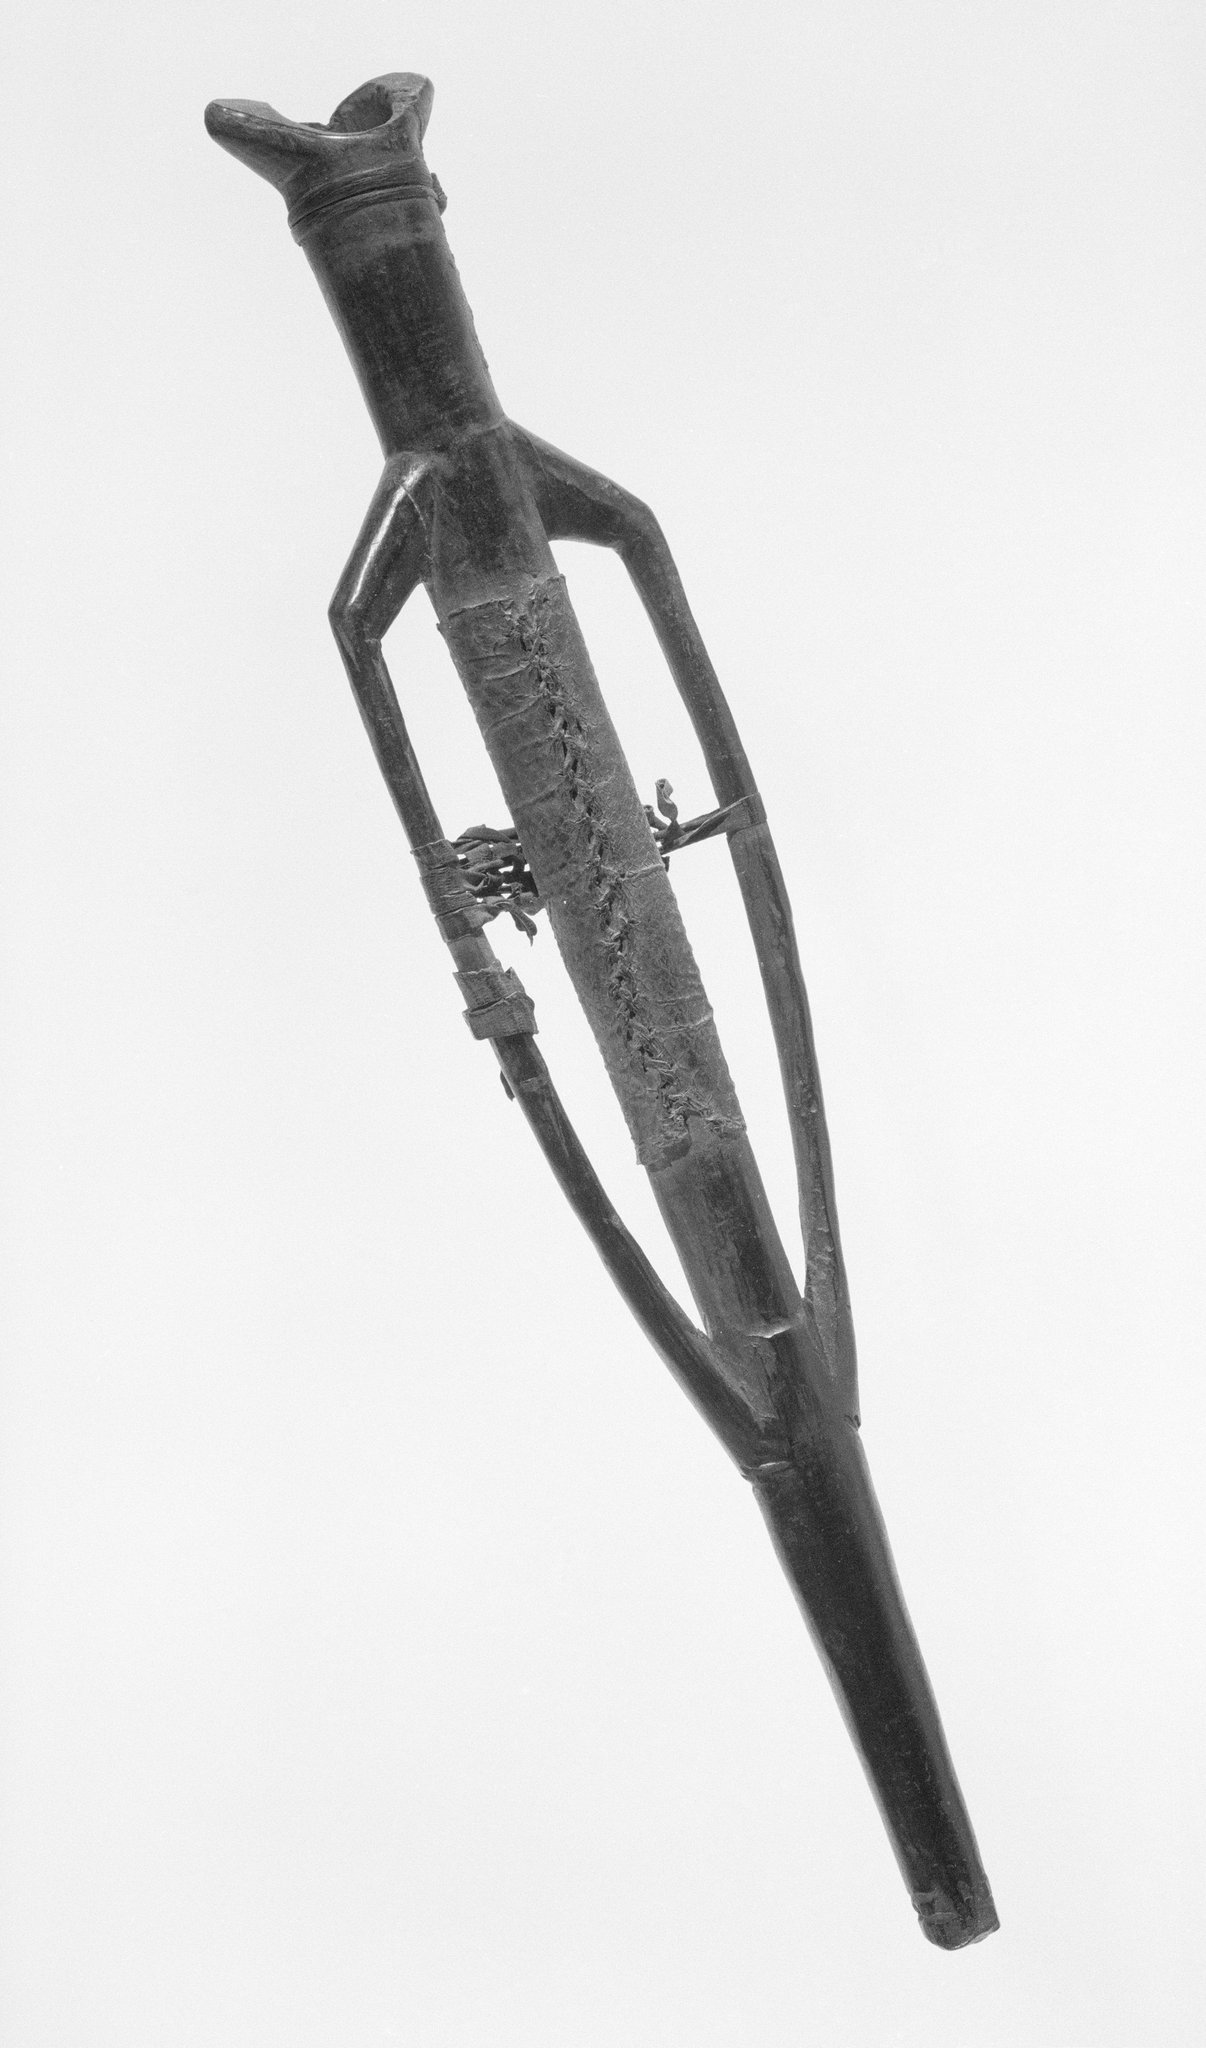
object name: whistle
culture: burkinabe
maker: bobo fing or samo tribe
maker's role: maker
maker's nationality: burkinabe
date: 1867-1900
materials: wood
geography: burkina faso